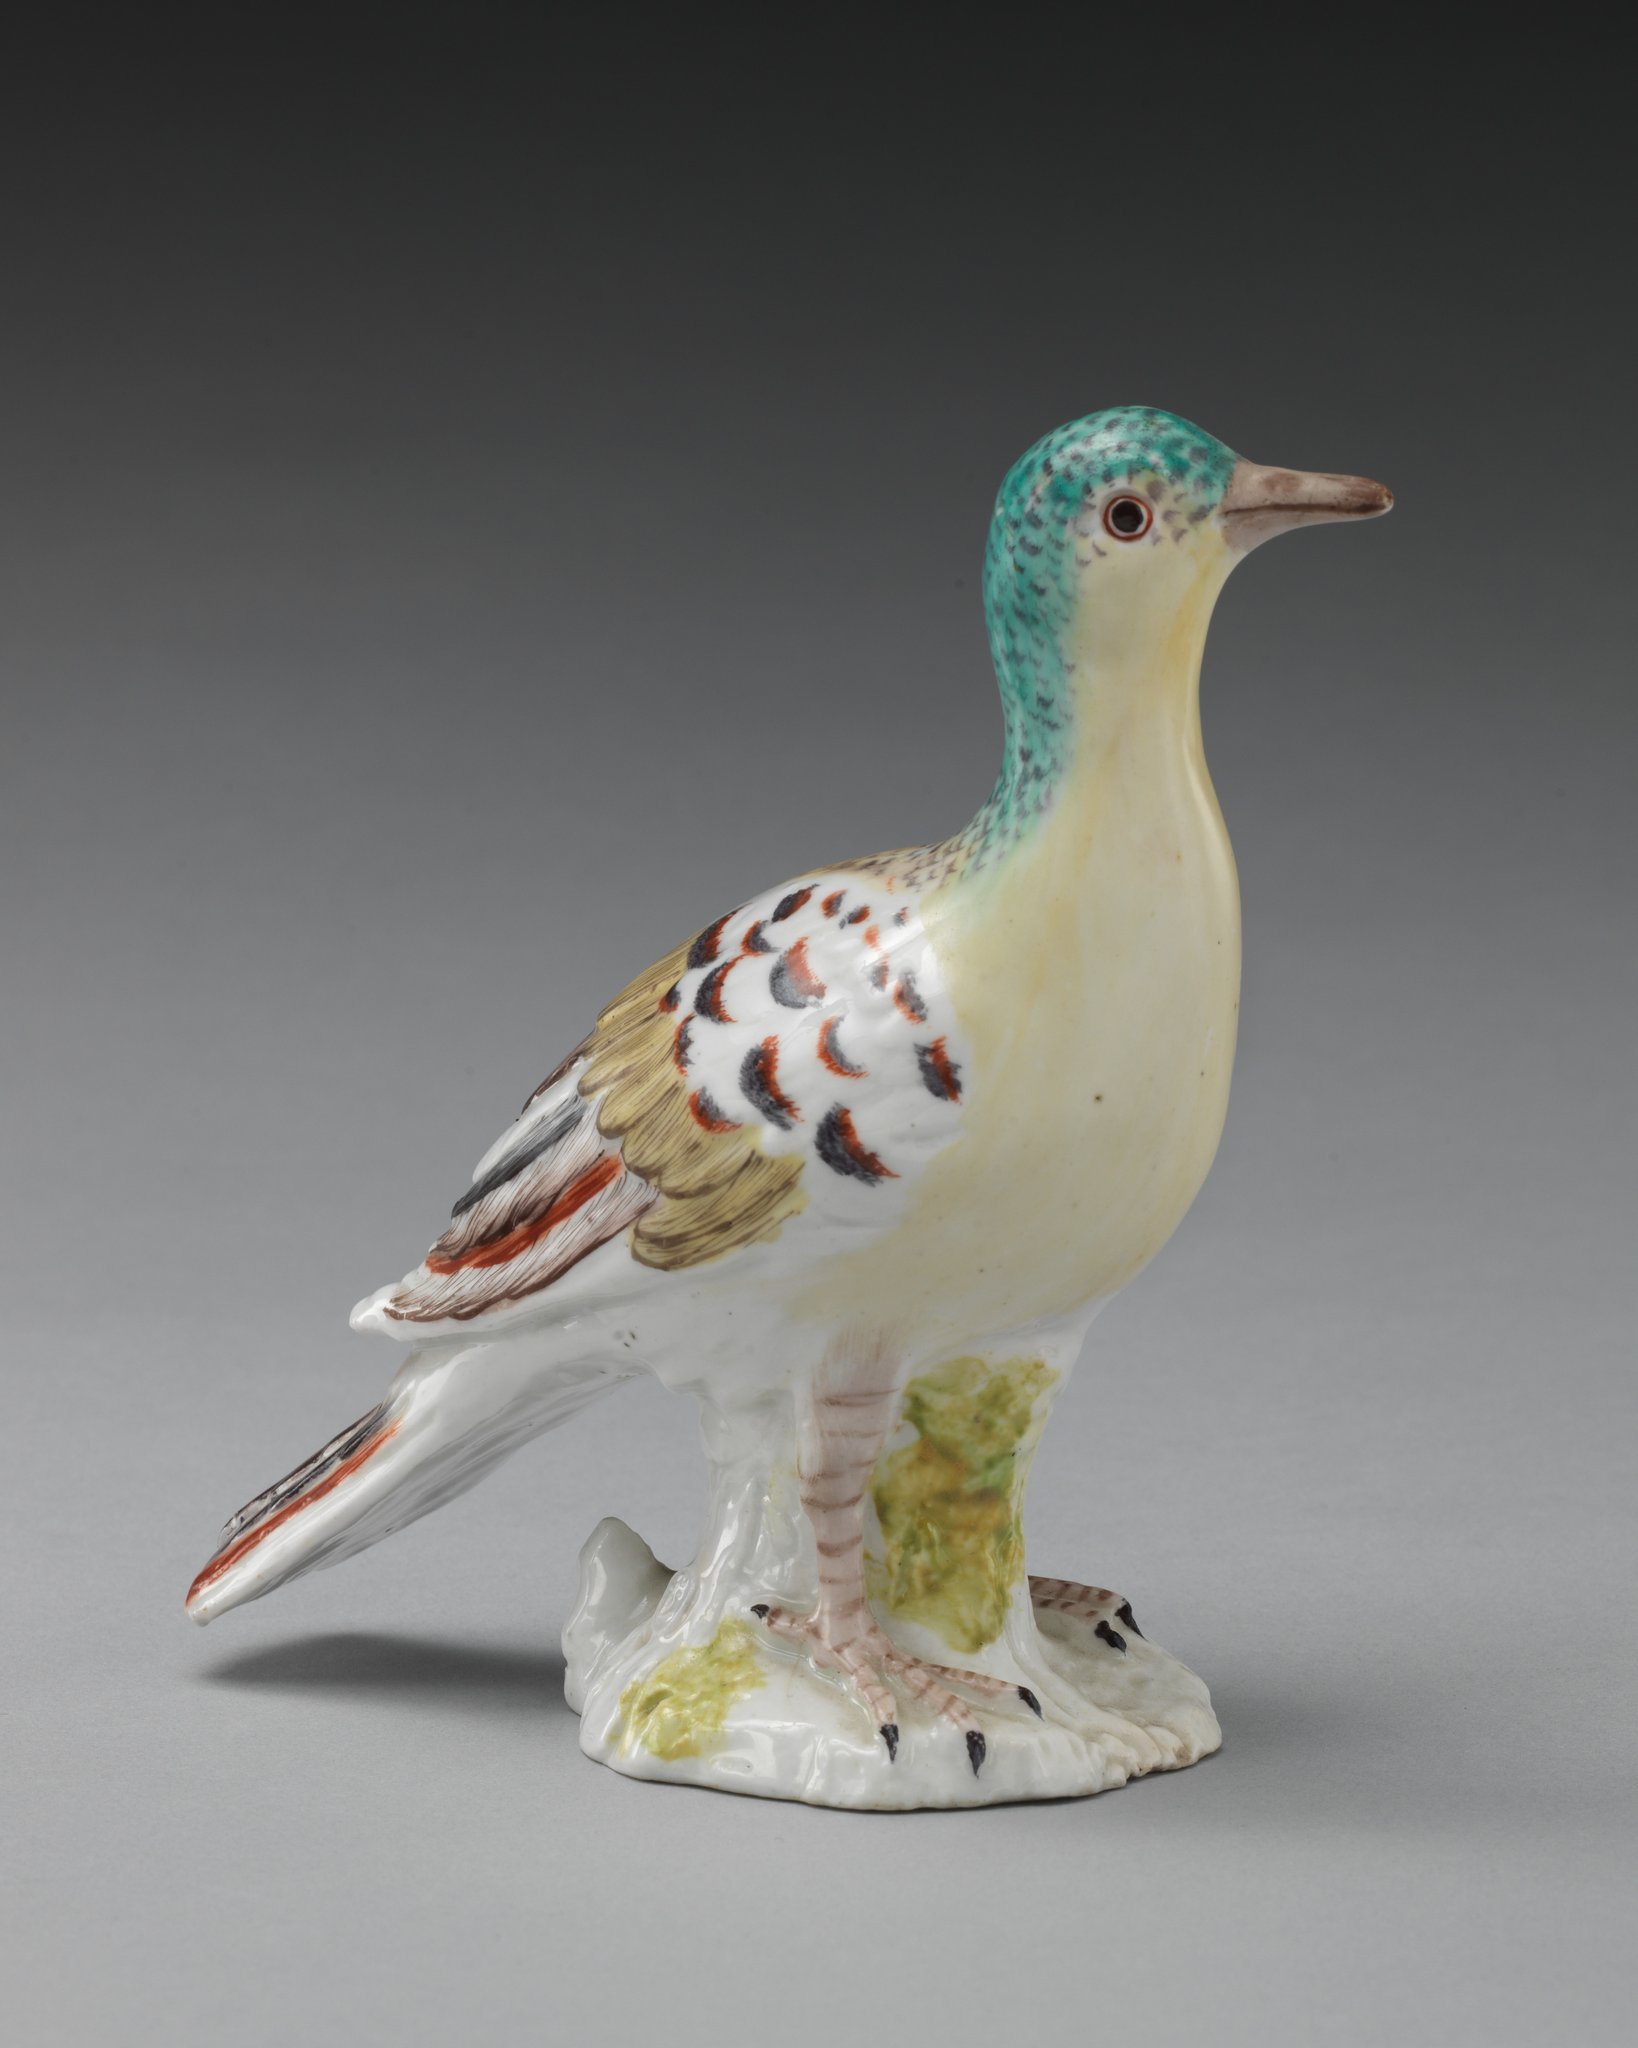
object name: figure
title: Dove (one of a pair)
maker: chelsea porcelain manufactory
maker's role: factory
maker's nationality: british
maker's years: 1744-1784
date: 1750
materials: soft paste porcelain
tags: doves